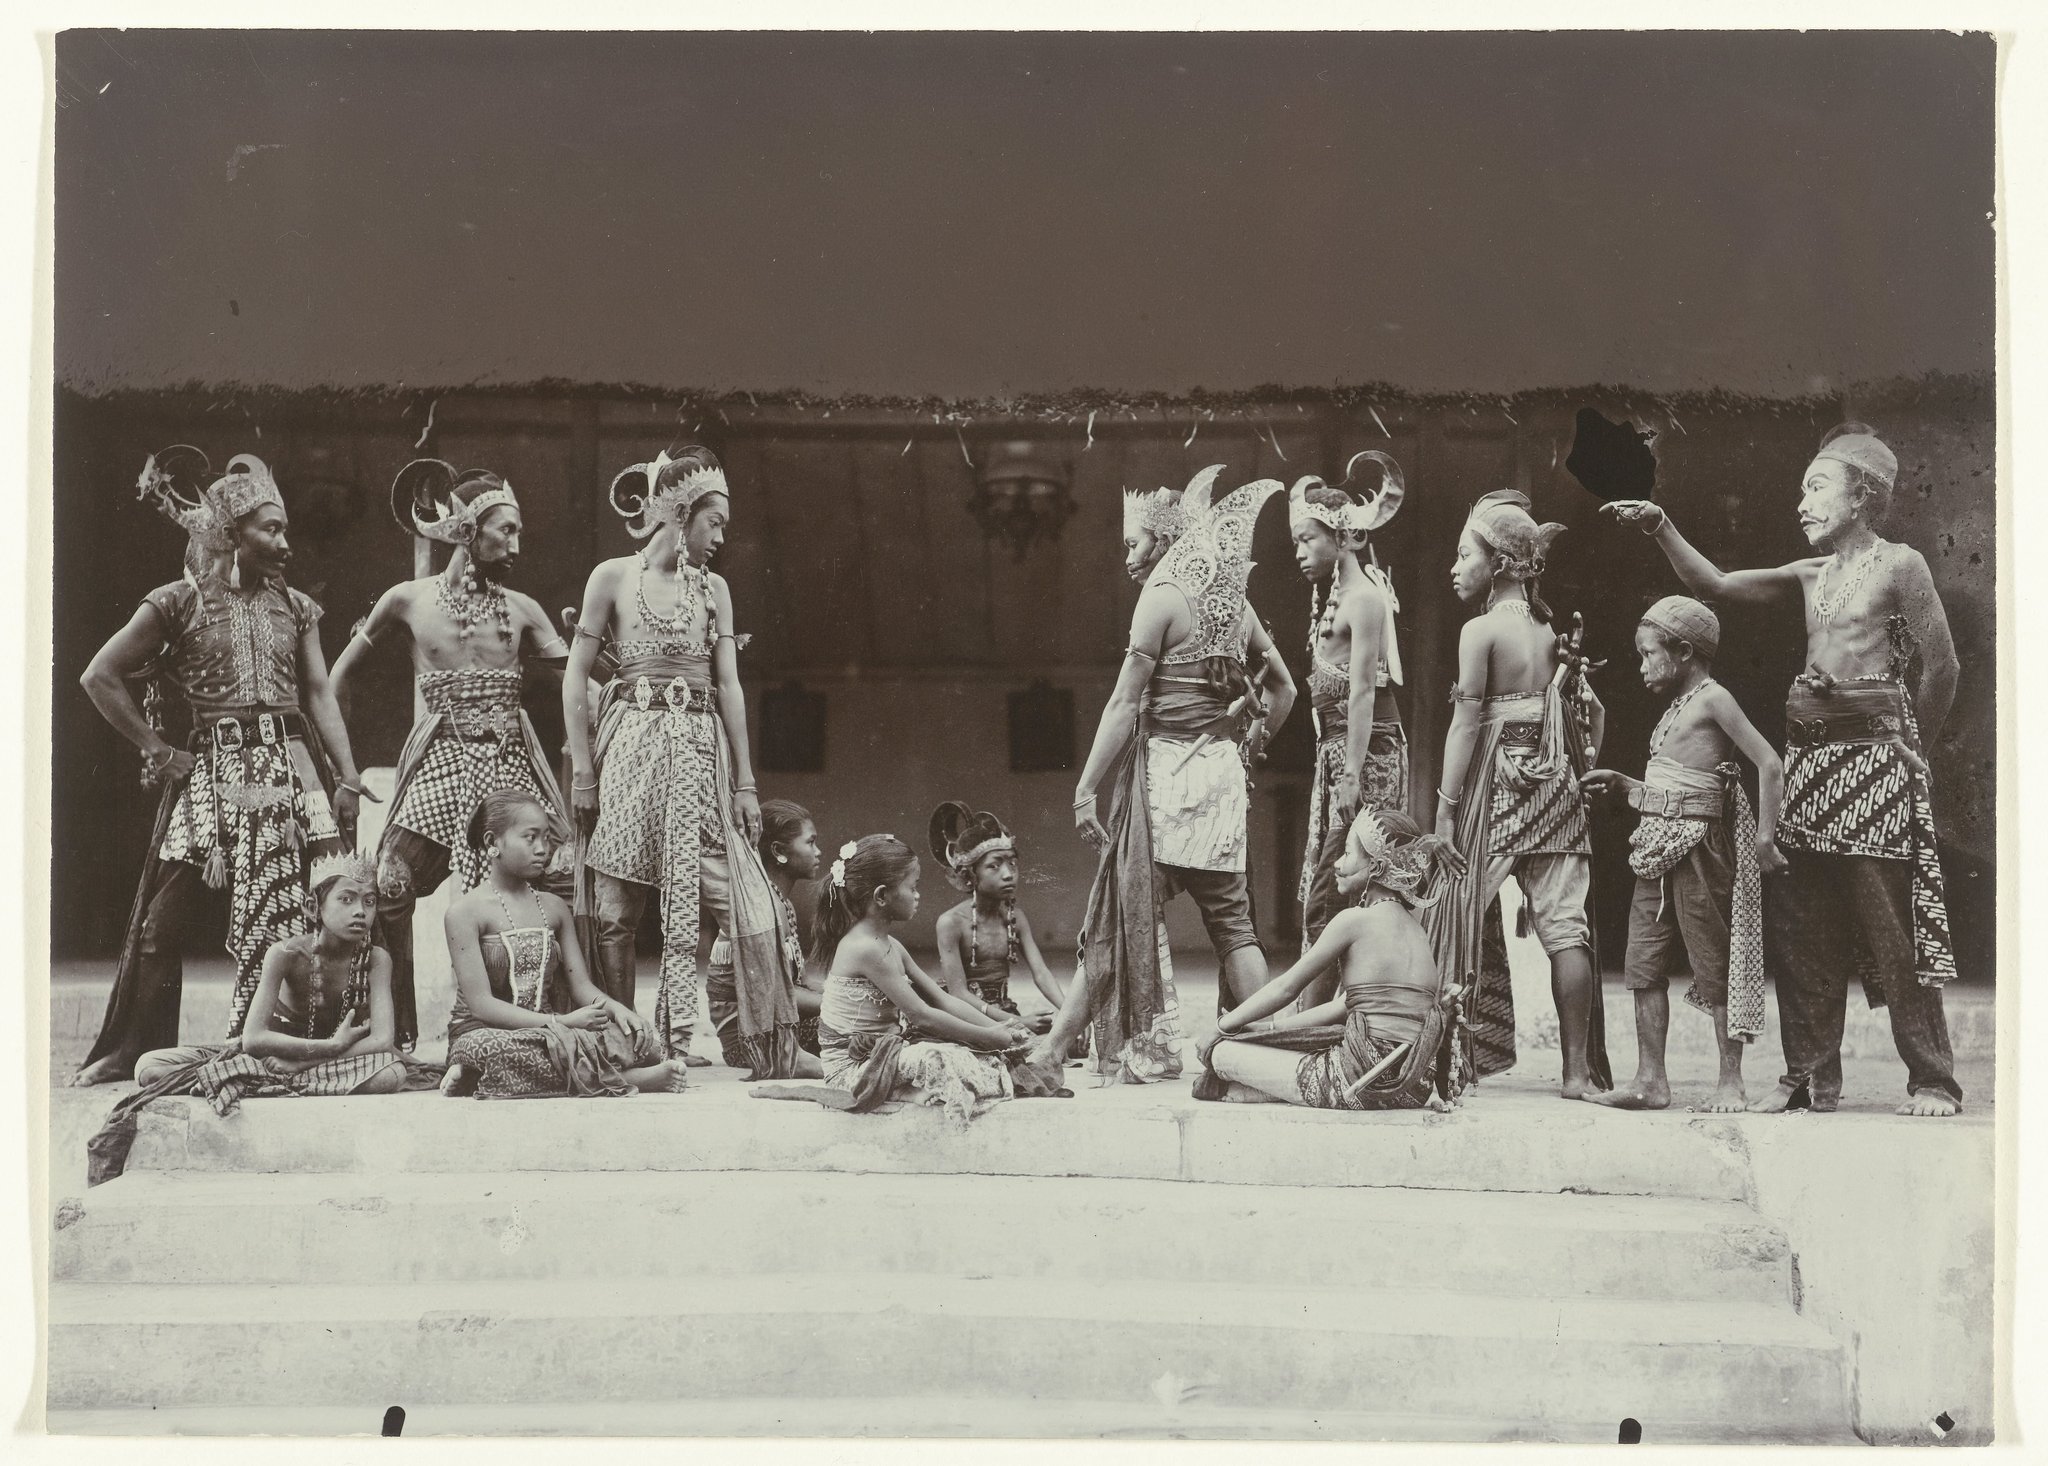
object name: photograph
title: Toneelspel door Javanen in kostuum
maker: kassian céphas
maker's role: fotograaf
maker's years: 1845-1912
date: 1867-1910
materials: cardboard, paper, photographic support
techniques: albumen print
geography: java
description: Toneelspel door Javanen in kostuum (Wajang?). Enkele van de mannen zijn wit gepoederd en enkele van hen dragen speciale kroonachtige hoofddeksels. Bij het spel zijn ook kinderen betrokken.